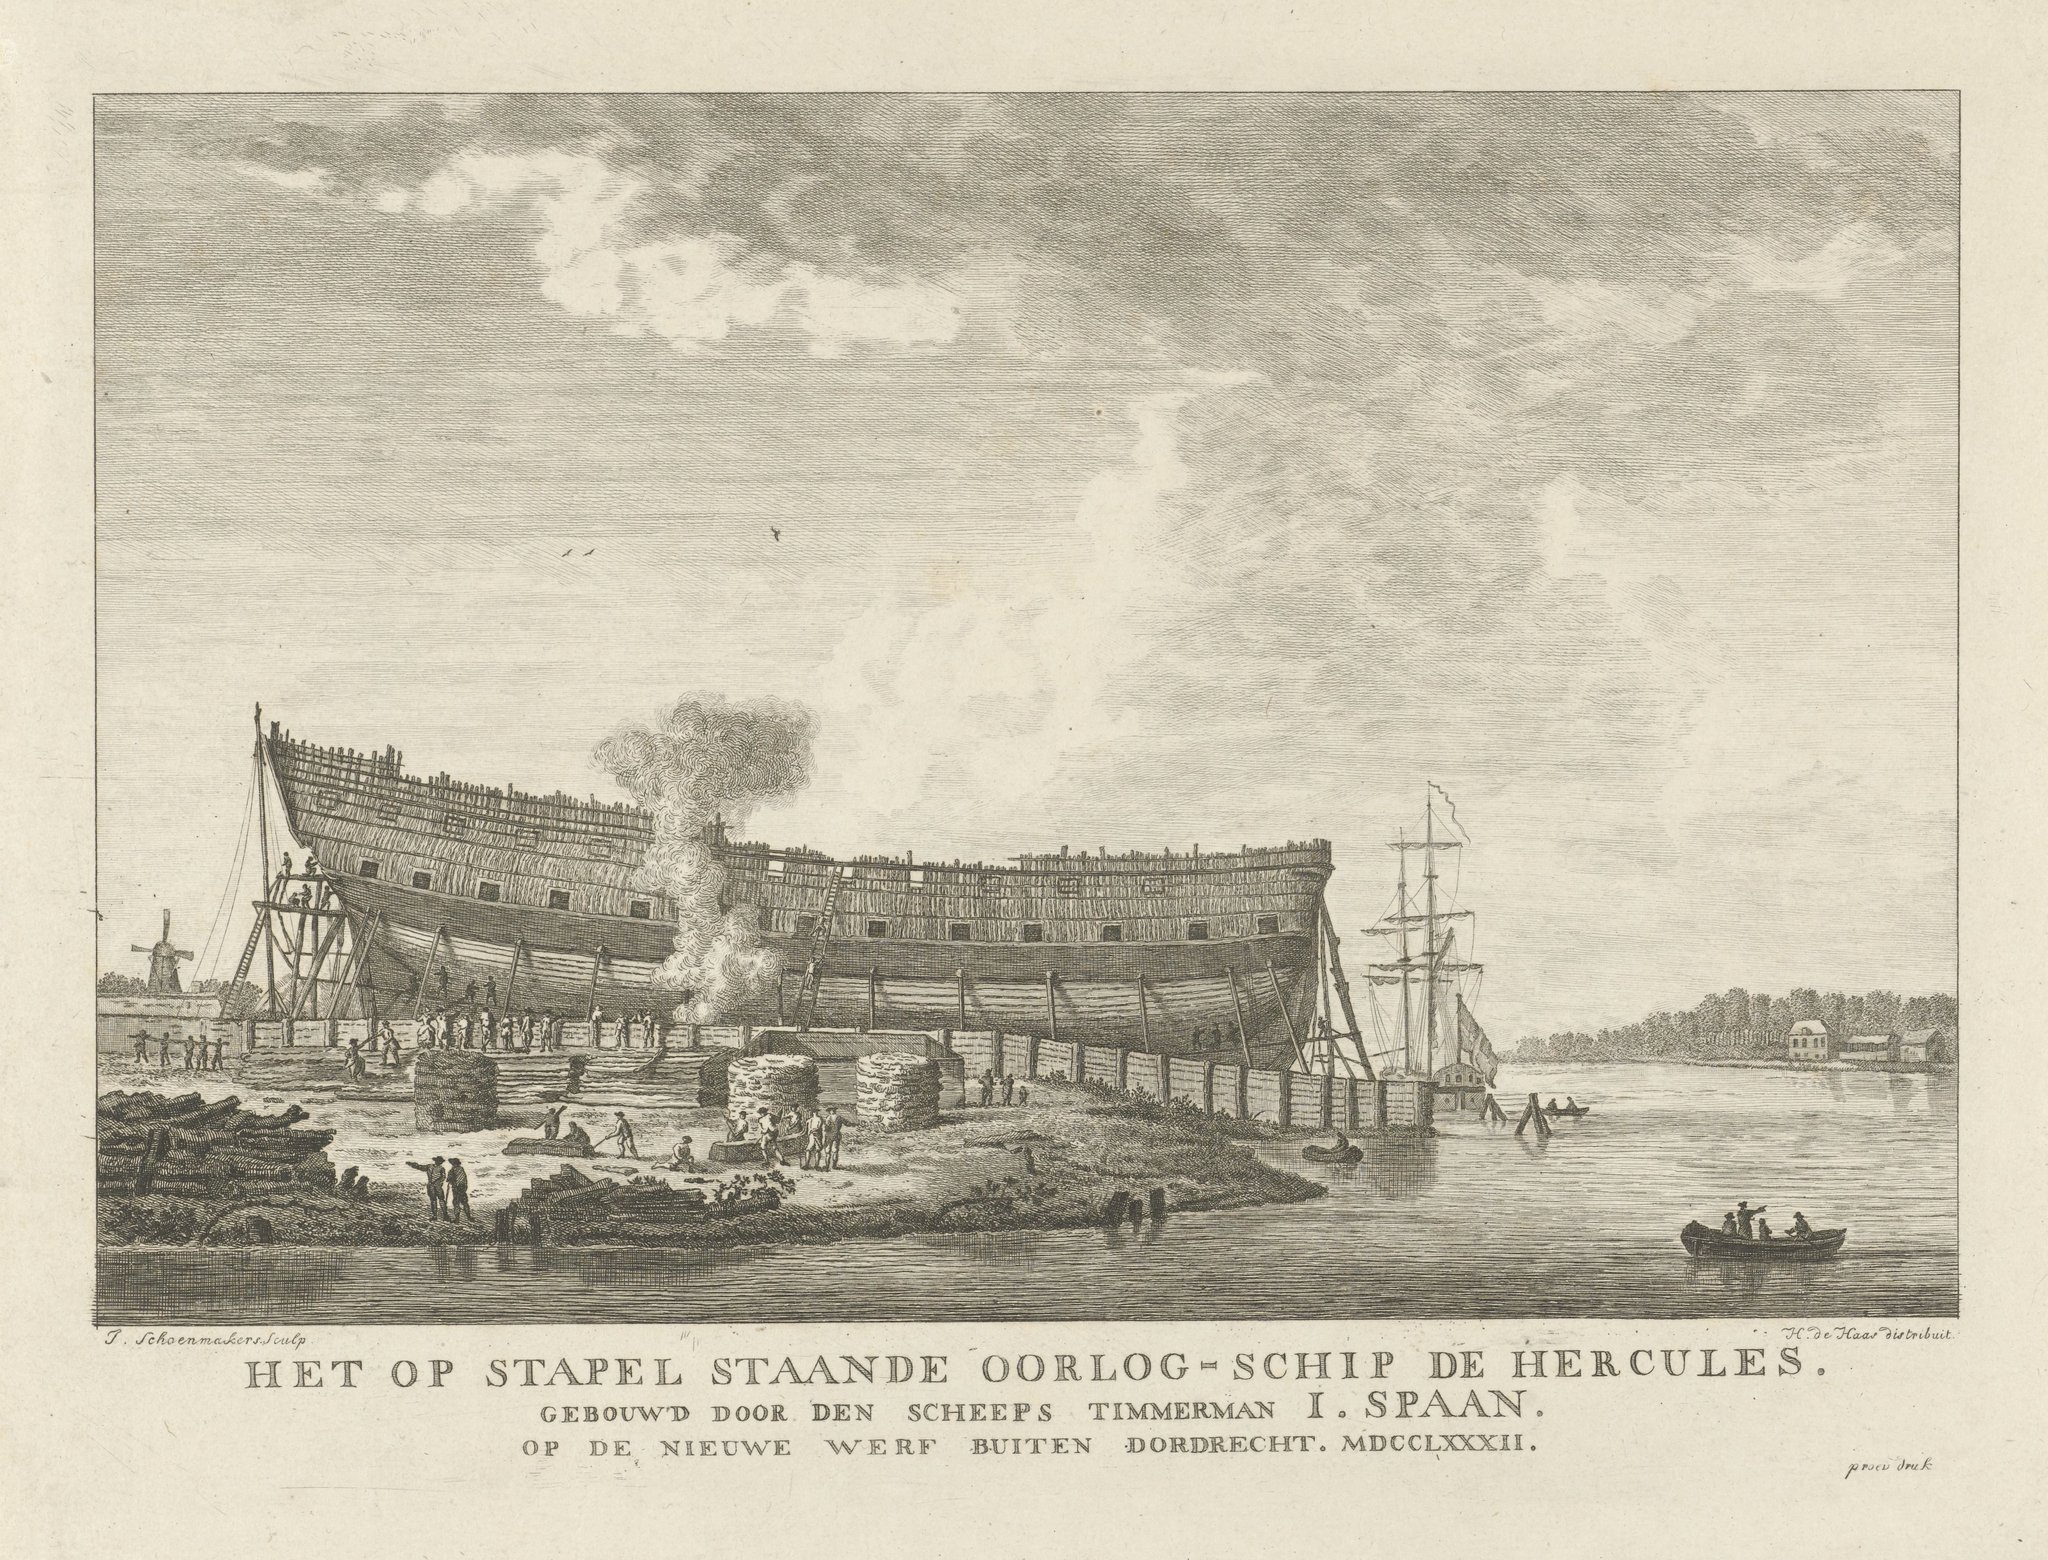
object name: print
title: Oorlogsschip Hercules staat op stapel, 1782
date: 1782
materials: paper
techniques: engraving, etching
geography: dordrecht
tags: slipway ~ shipbuilding, dordrecht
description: Het nog onafgebouwde linieschip Hercules staat op stapel in de scheepswerf buiten Dordrecht, april 1782. De bouw van het schip vond plaats in de periode 1781-1782 naar scheepsbouwtekeningen van Pieter van Zwijndregt op de nieuwe scheepswerf van scheepstimmerman I. Spaan. De tewaterlating vond plaats op 12 april 1782. Bij de prent behoort een pendant.